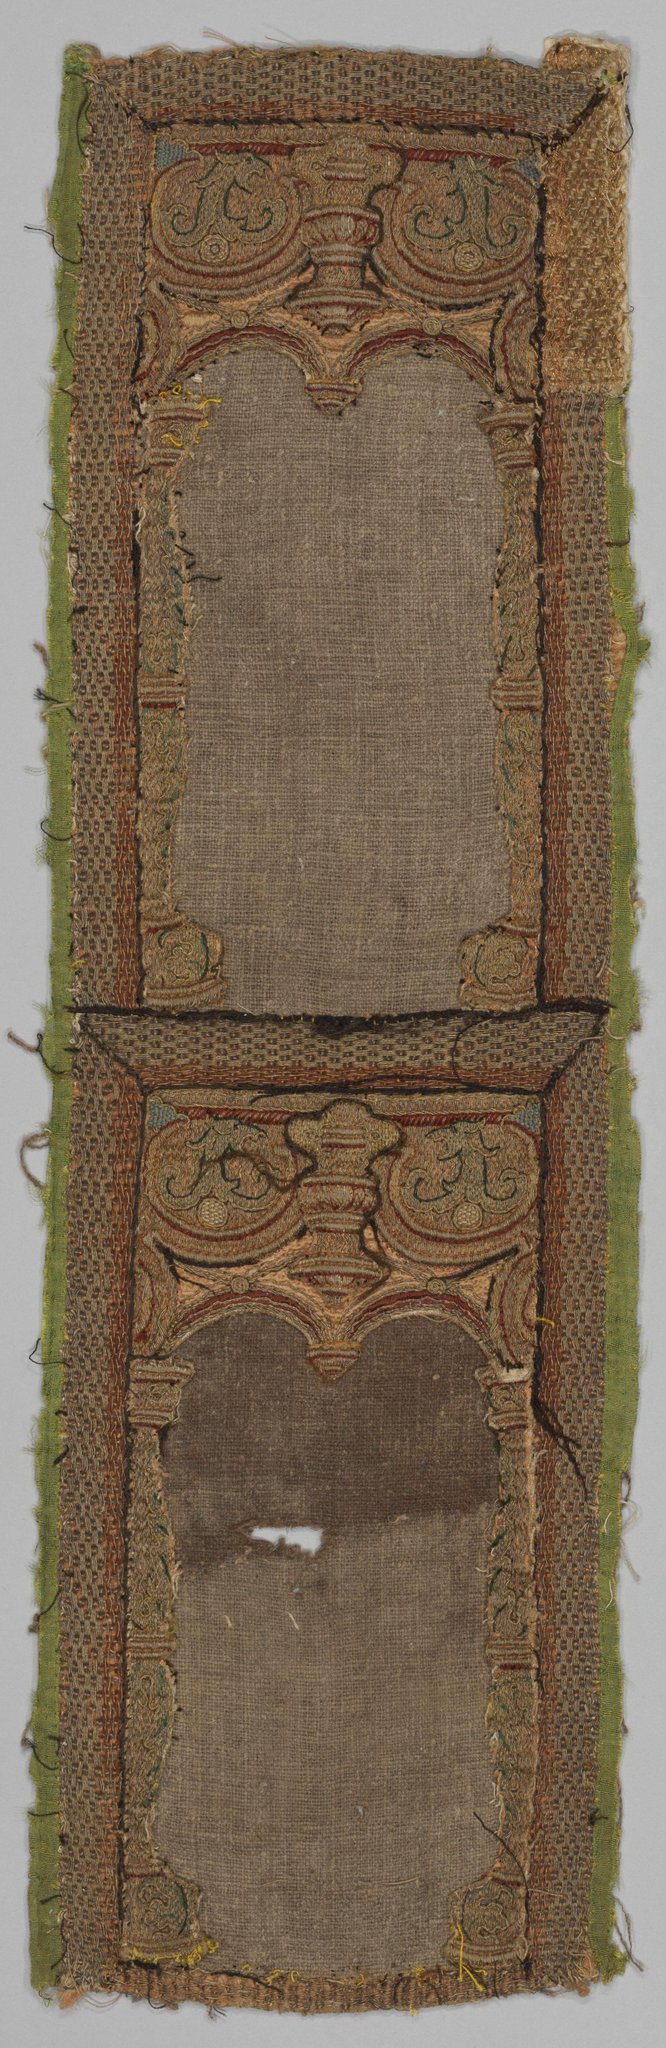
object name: aurifries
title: Aurifries met borduurwerk van zijde en gouddraad op linnen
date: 1525-1530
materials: gold thread, linen, silk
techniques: embroidered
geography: southern netherlands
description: Aurifries waarvan delen van het borduurwerk zijn verwijderd. Deze delen zijn apart opgezet en genummerd BK-NM-5440-B en C.